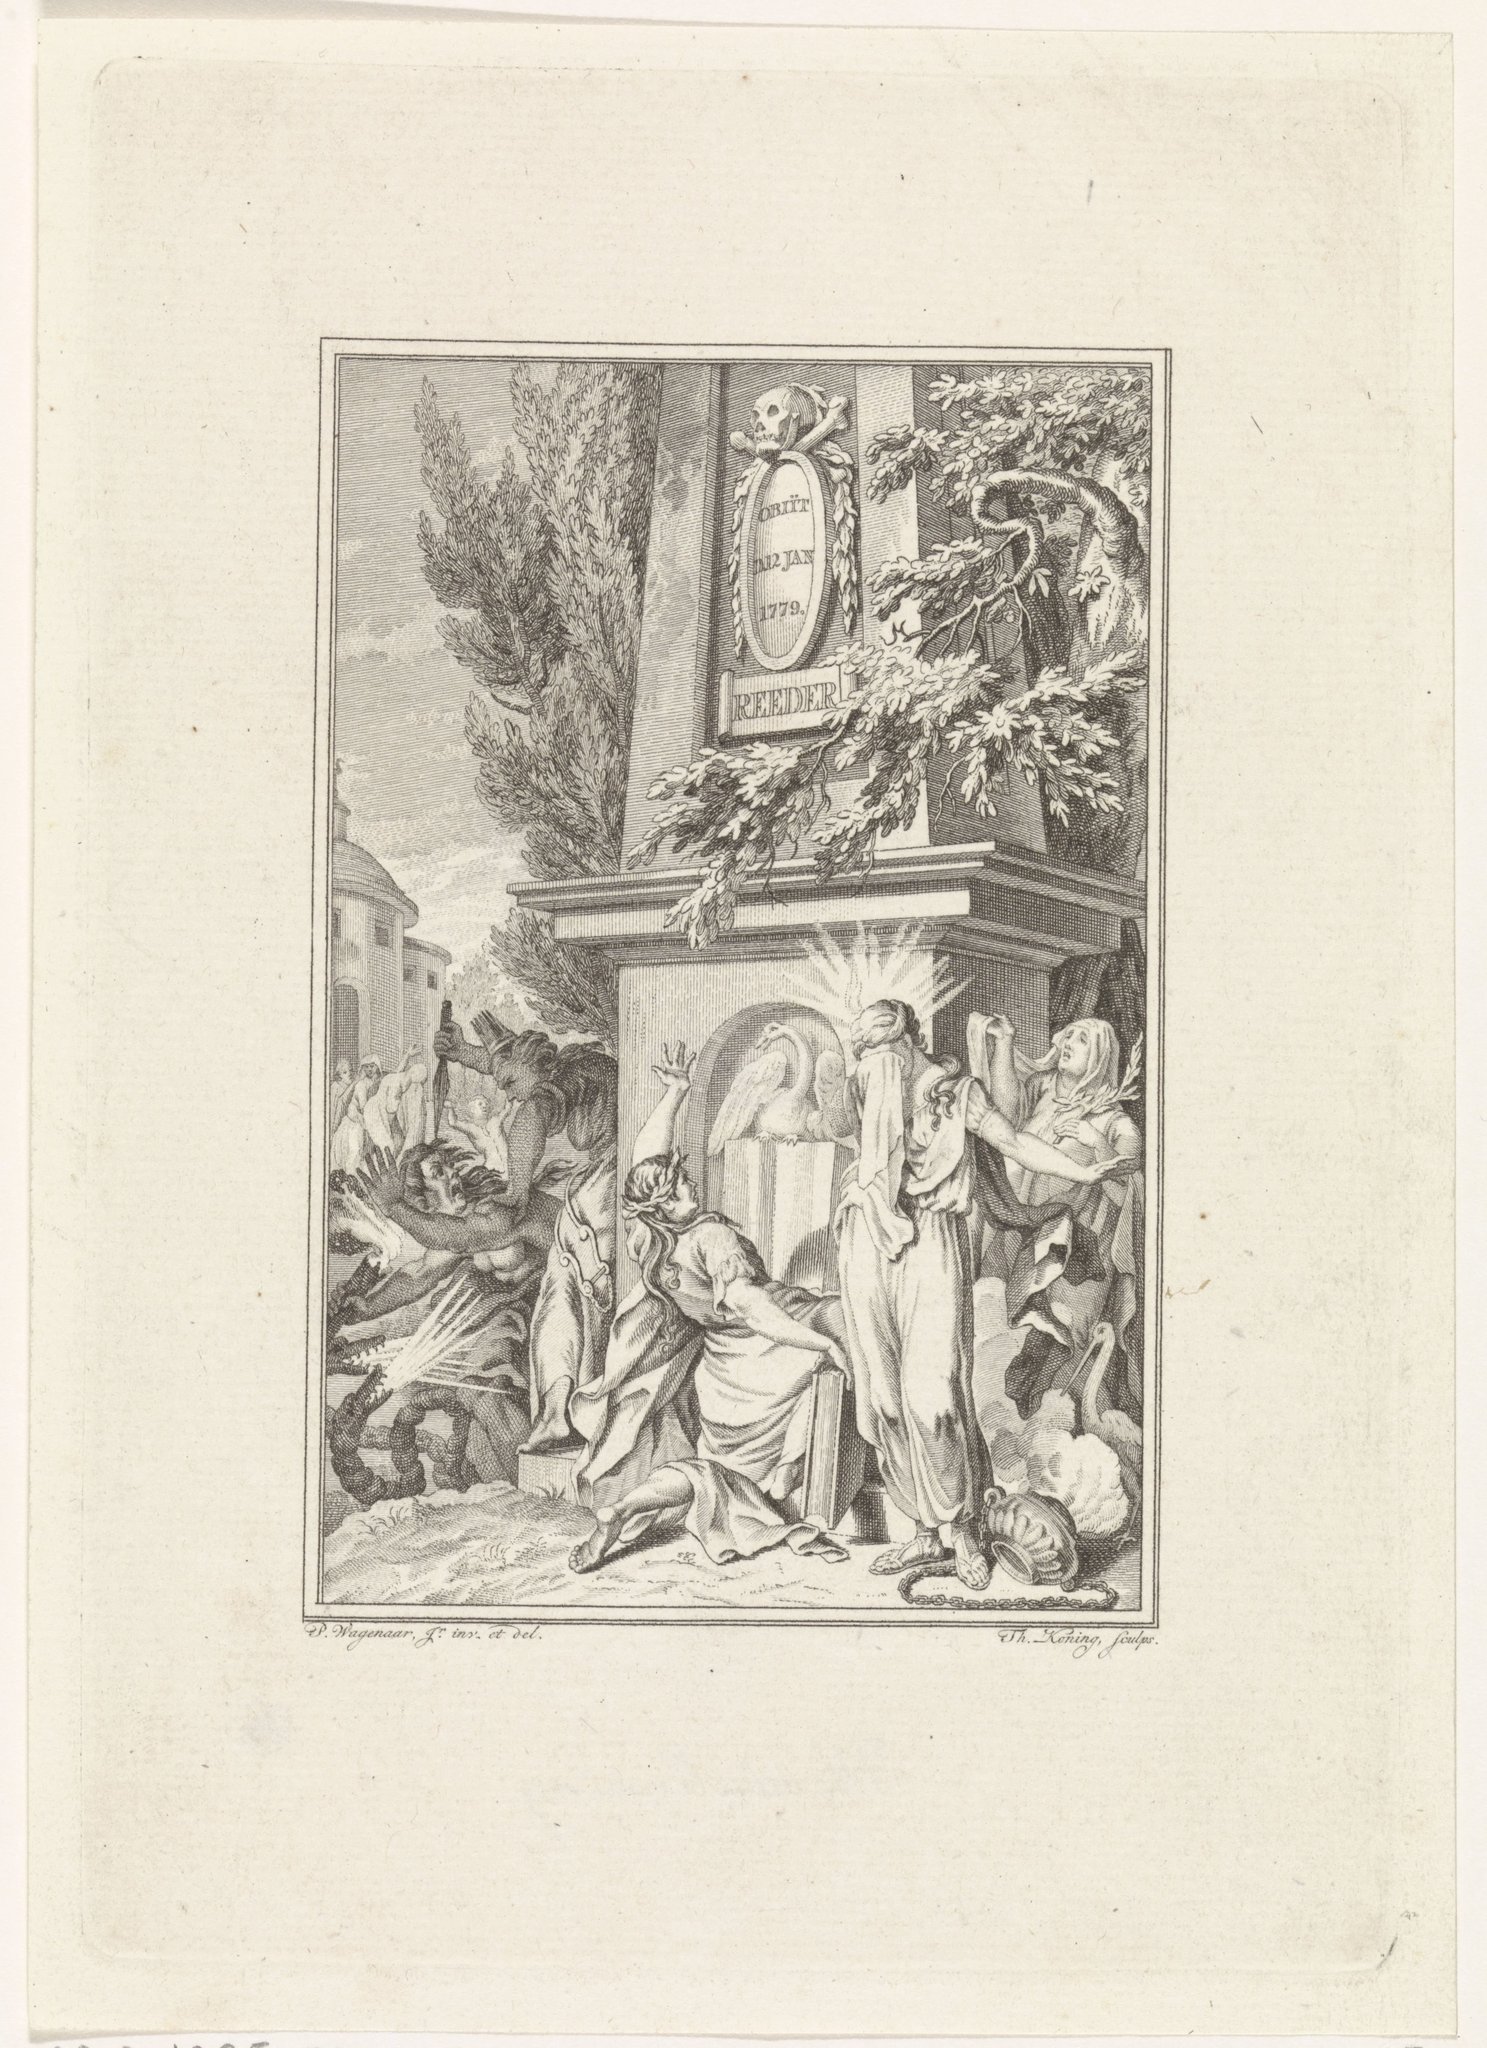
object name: print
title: Grafmonument voor Lucas Reeder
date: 1779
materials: paper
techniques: engraving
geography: amsterdam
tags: leiden, shore-birds and wading-birds: stork, fidelity; 'fedeltà' (ripa), water-birds: swan, pain, sorrow, sadness; 'dolore', 'dolore di zeusi' (ripa), grave-building, monumental tomb, invidia (envy) as roman personification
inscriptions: collector's mark: Lugt 2228, collector's mark: Lugt 2760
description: Allegorisch grafmonument voor de predikant Lucas Reeder. Voor het gedenkteken, dat gedecoreerd is met een zwaan en een schedel, staan personificaties van Verdriet, Geloof en Trouw. Rechts staat een ooievaar en ligt een omgevallen wierookvat. Links wordt de personificatie van Nijd neergestoken.